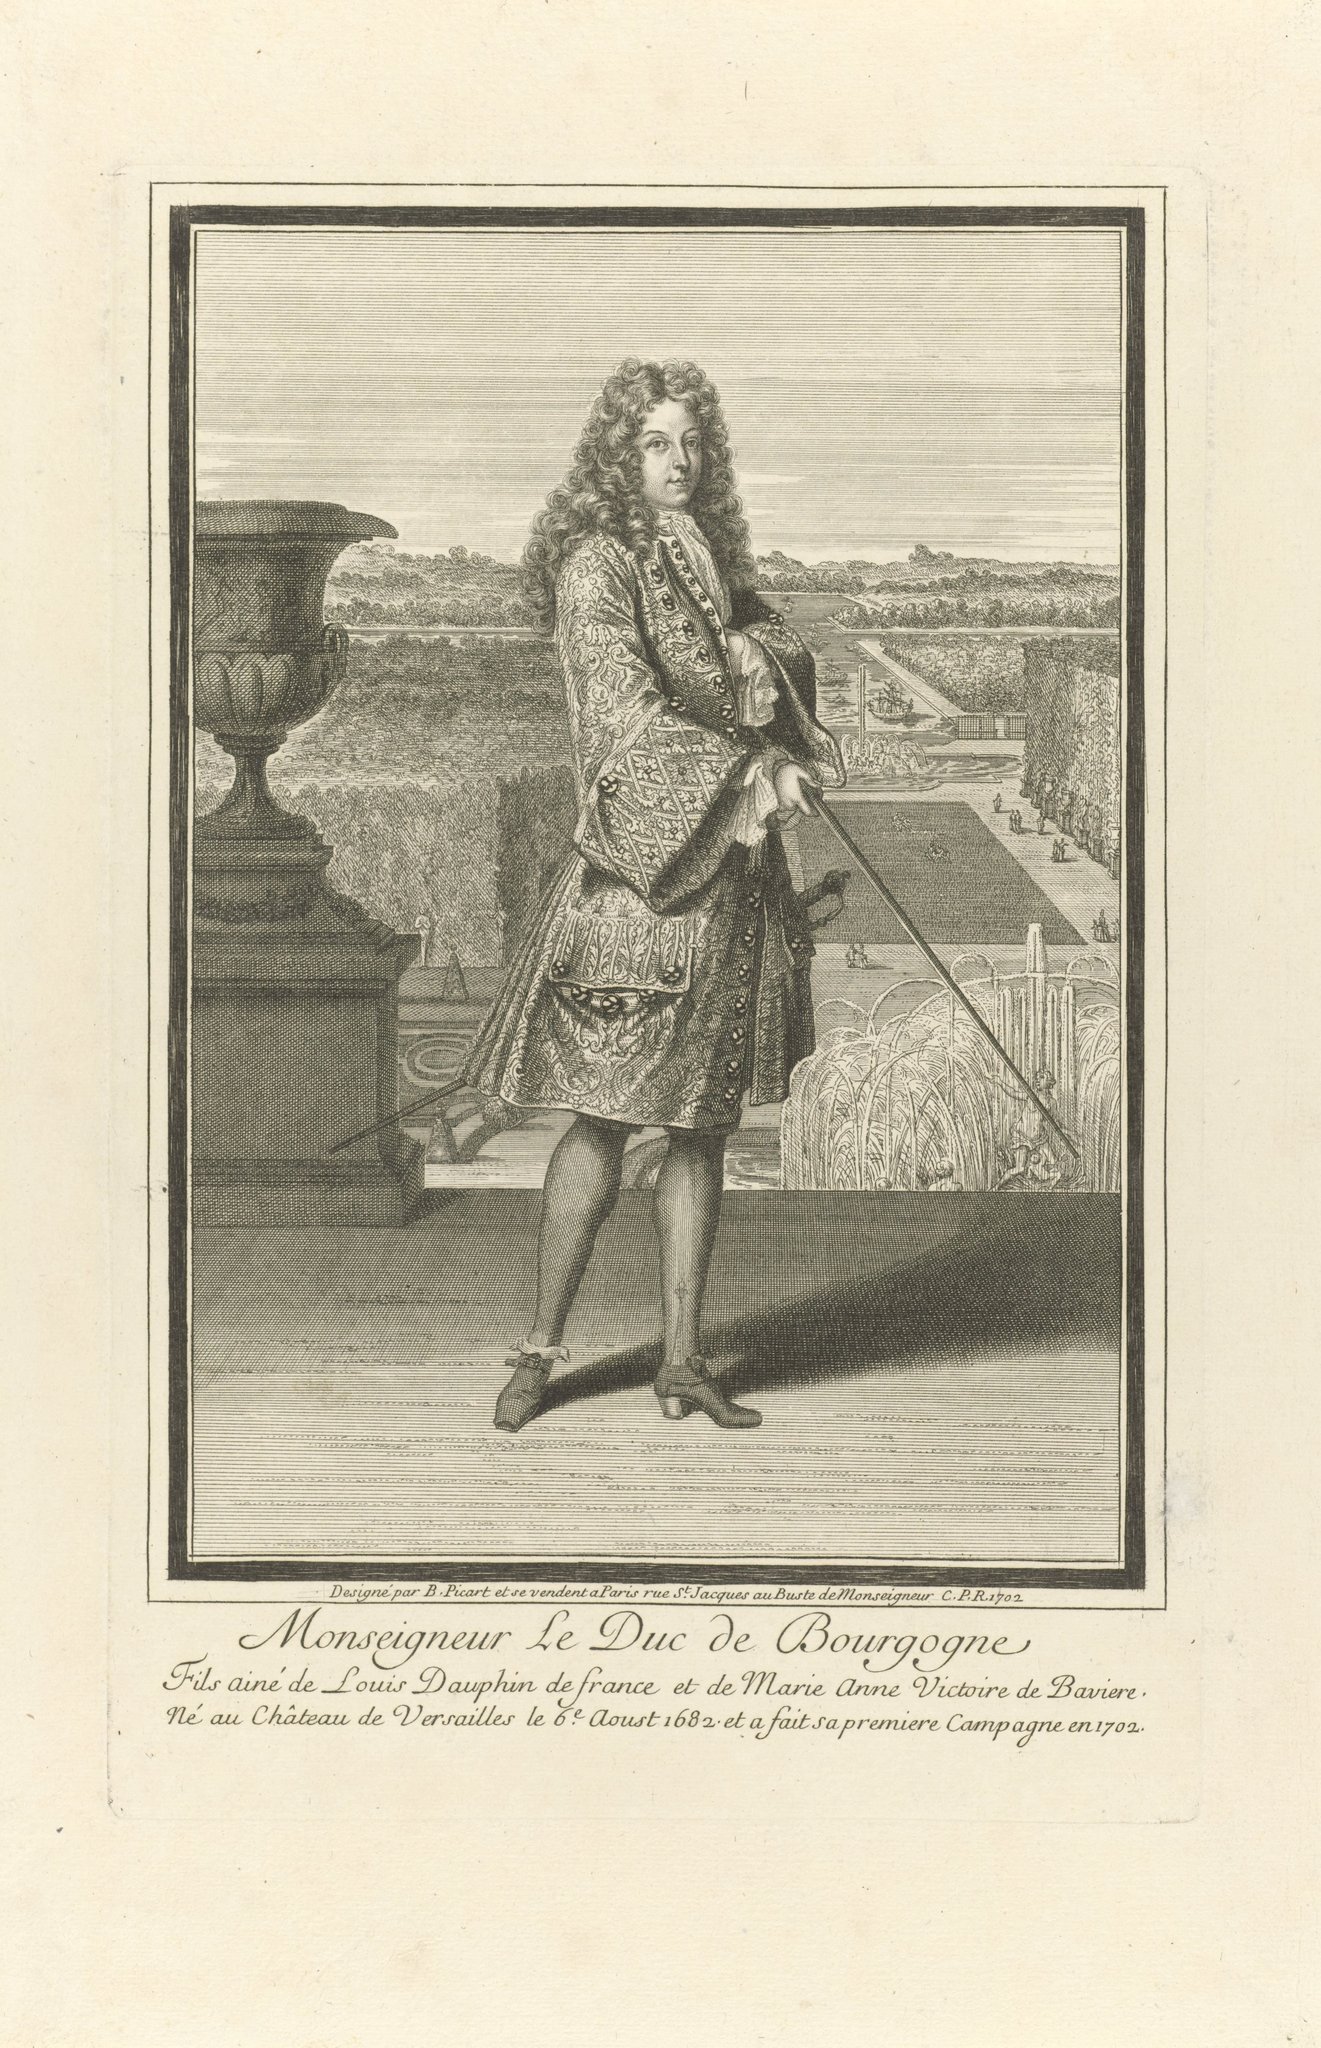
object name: print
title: Portret van Lodewijk, hertog van Bourgondië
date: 1702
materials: paper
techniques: engraving, etching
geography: paris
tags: lodewijk van frankrijk (hertog van bourgondië), cultivation of (ornamental) garden, styles of hairdress (allonge), coat (justaucorps) (+ men's clothes), garden fountain, clothes, costume (+ men's clothes), trousers, breeches, etc. (breeches) (+ men's clothes)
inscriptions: date: ‘1702’, caption: ‘Fils ainé de Louis Dauphin de france et de Marie Anne Victoire de Baviere / Né au Chateau de Versailles le 6e Aoust 1682 et a fait sa premiere Campagne en 1702.’, collector's mark: Lugt 2228, signature: ‘Designé par B. Picart et se vendent a Paris rue St. jacques au Buste de Monseigneur’, title: ‘Monseigneur Le Duc de Bourgogne’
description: Portret van Lodewijk, hertog van Bourgondië en dauphin van Frankrijk. Hij staat op een bordes, een wandelstok in de hand. Op de achtergrond een gezicht op de tuin van Versailles. In de marge een drieregelig onderschrift in het Frans.